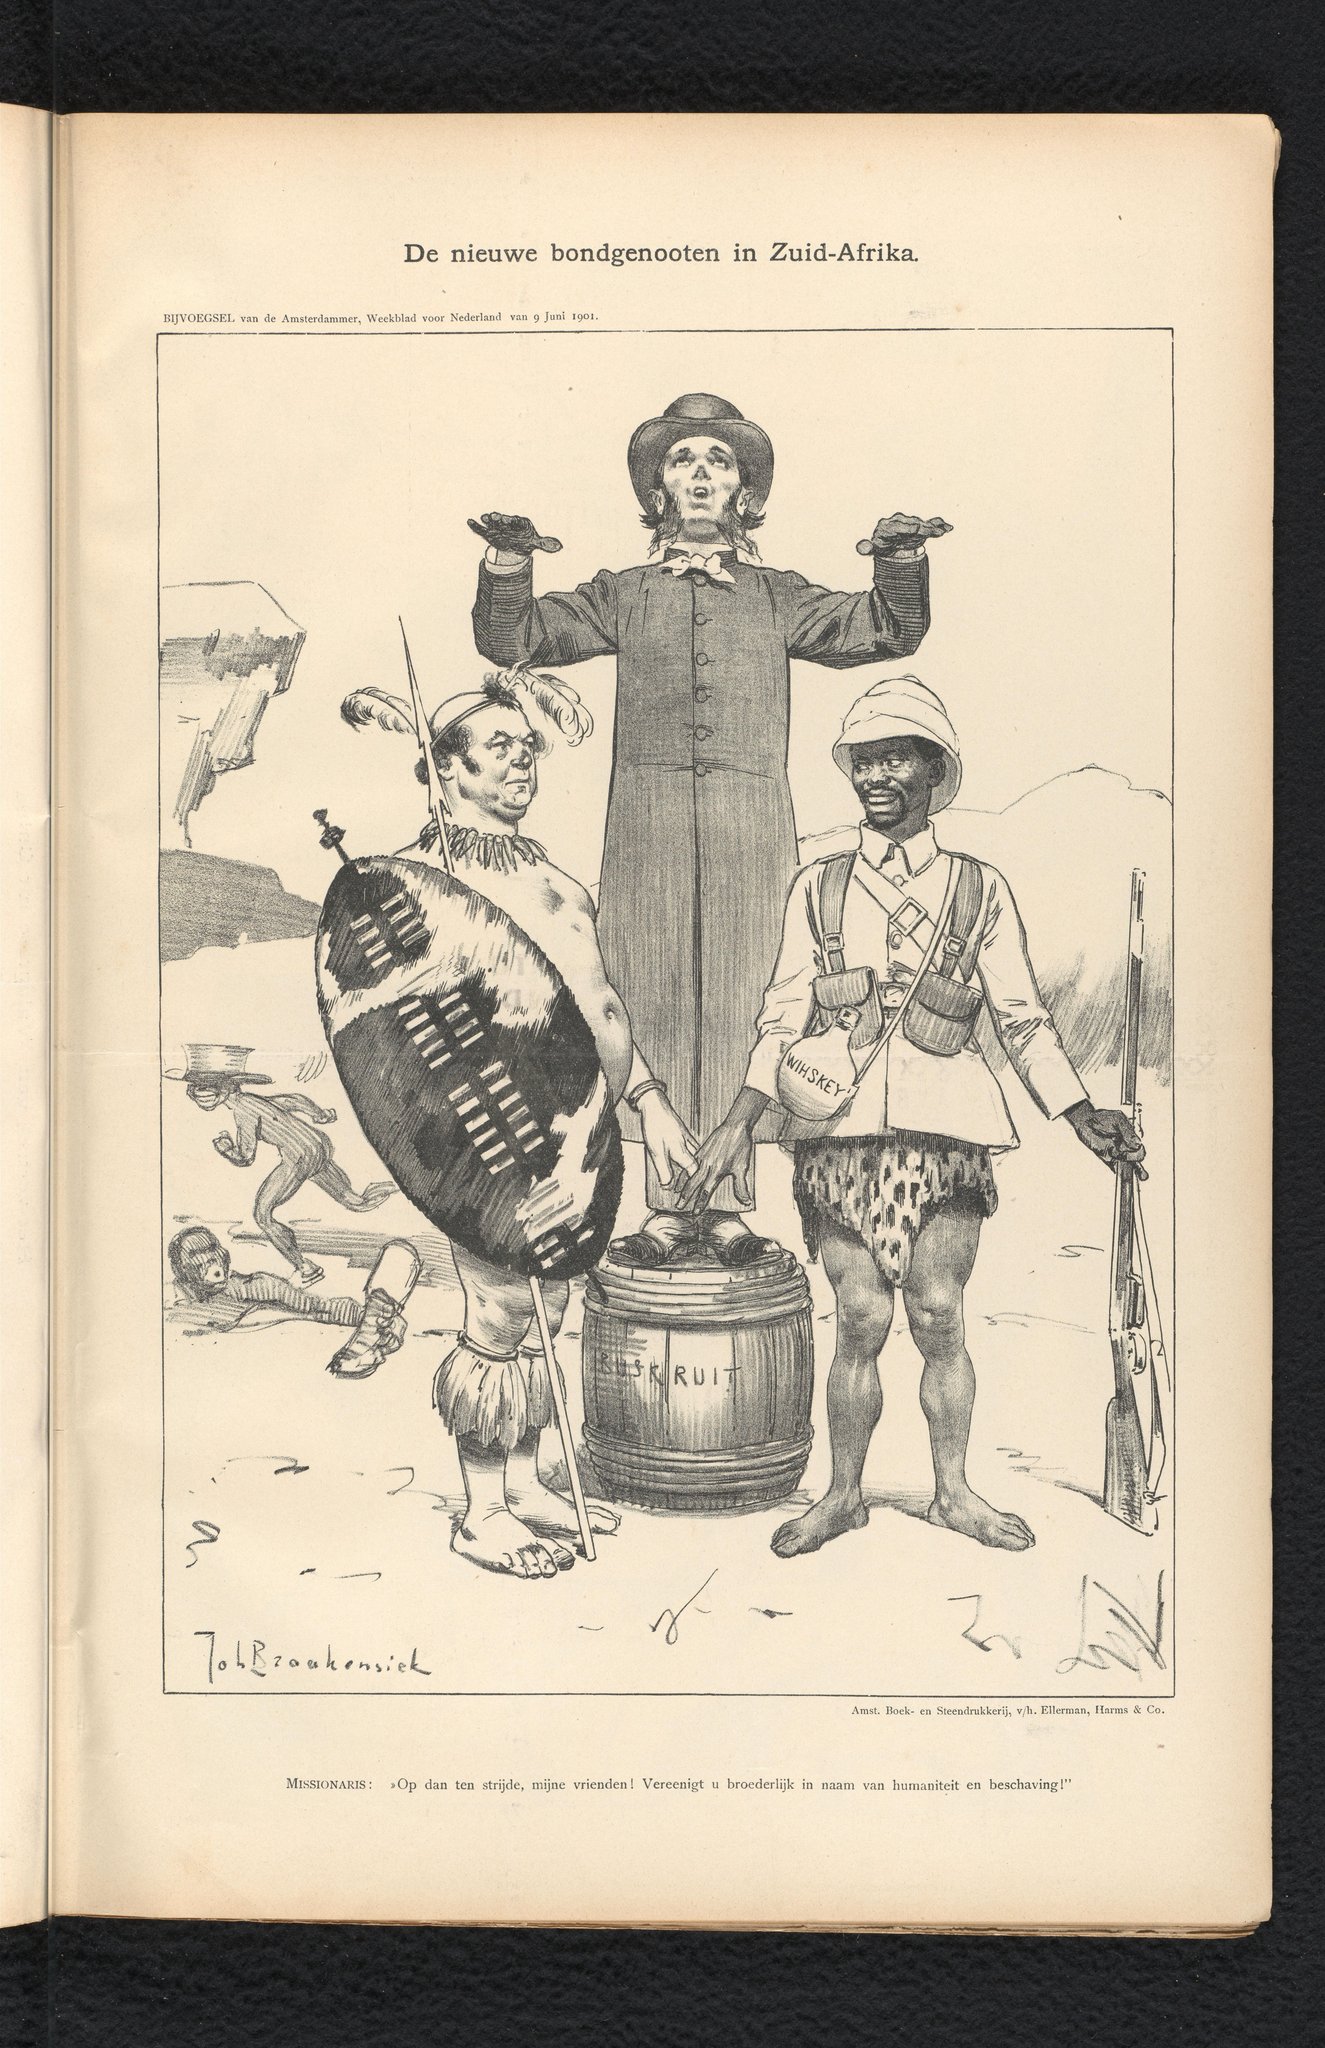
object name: cartoon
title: De nieuwe bondgenooten in Zuid-Afrika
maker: johan braakensiek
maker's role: draughtsman, print maker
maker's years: 1858-1940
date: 1901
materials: paper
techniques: lithograph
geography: netherlands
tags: african peoples (zulus), personifications of countries, nations, states, districts, etc., blessing the married couple, spreading the gospel; missionary work, political caricatures and satires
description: Het bondgenootschap als huwelijk tussen John Bull (Engeland) en een Zulukrijger krijgt de zegen van een missionaris. Beide mannen hebben kleding en wapens van elkaar uitgewisseld. De zendeling staat op een vat met buskruit.